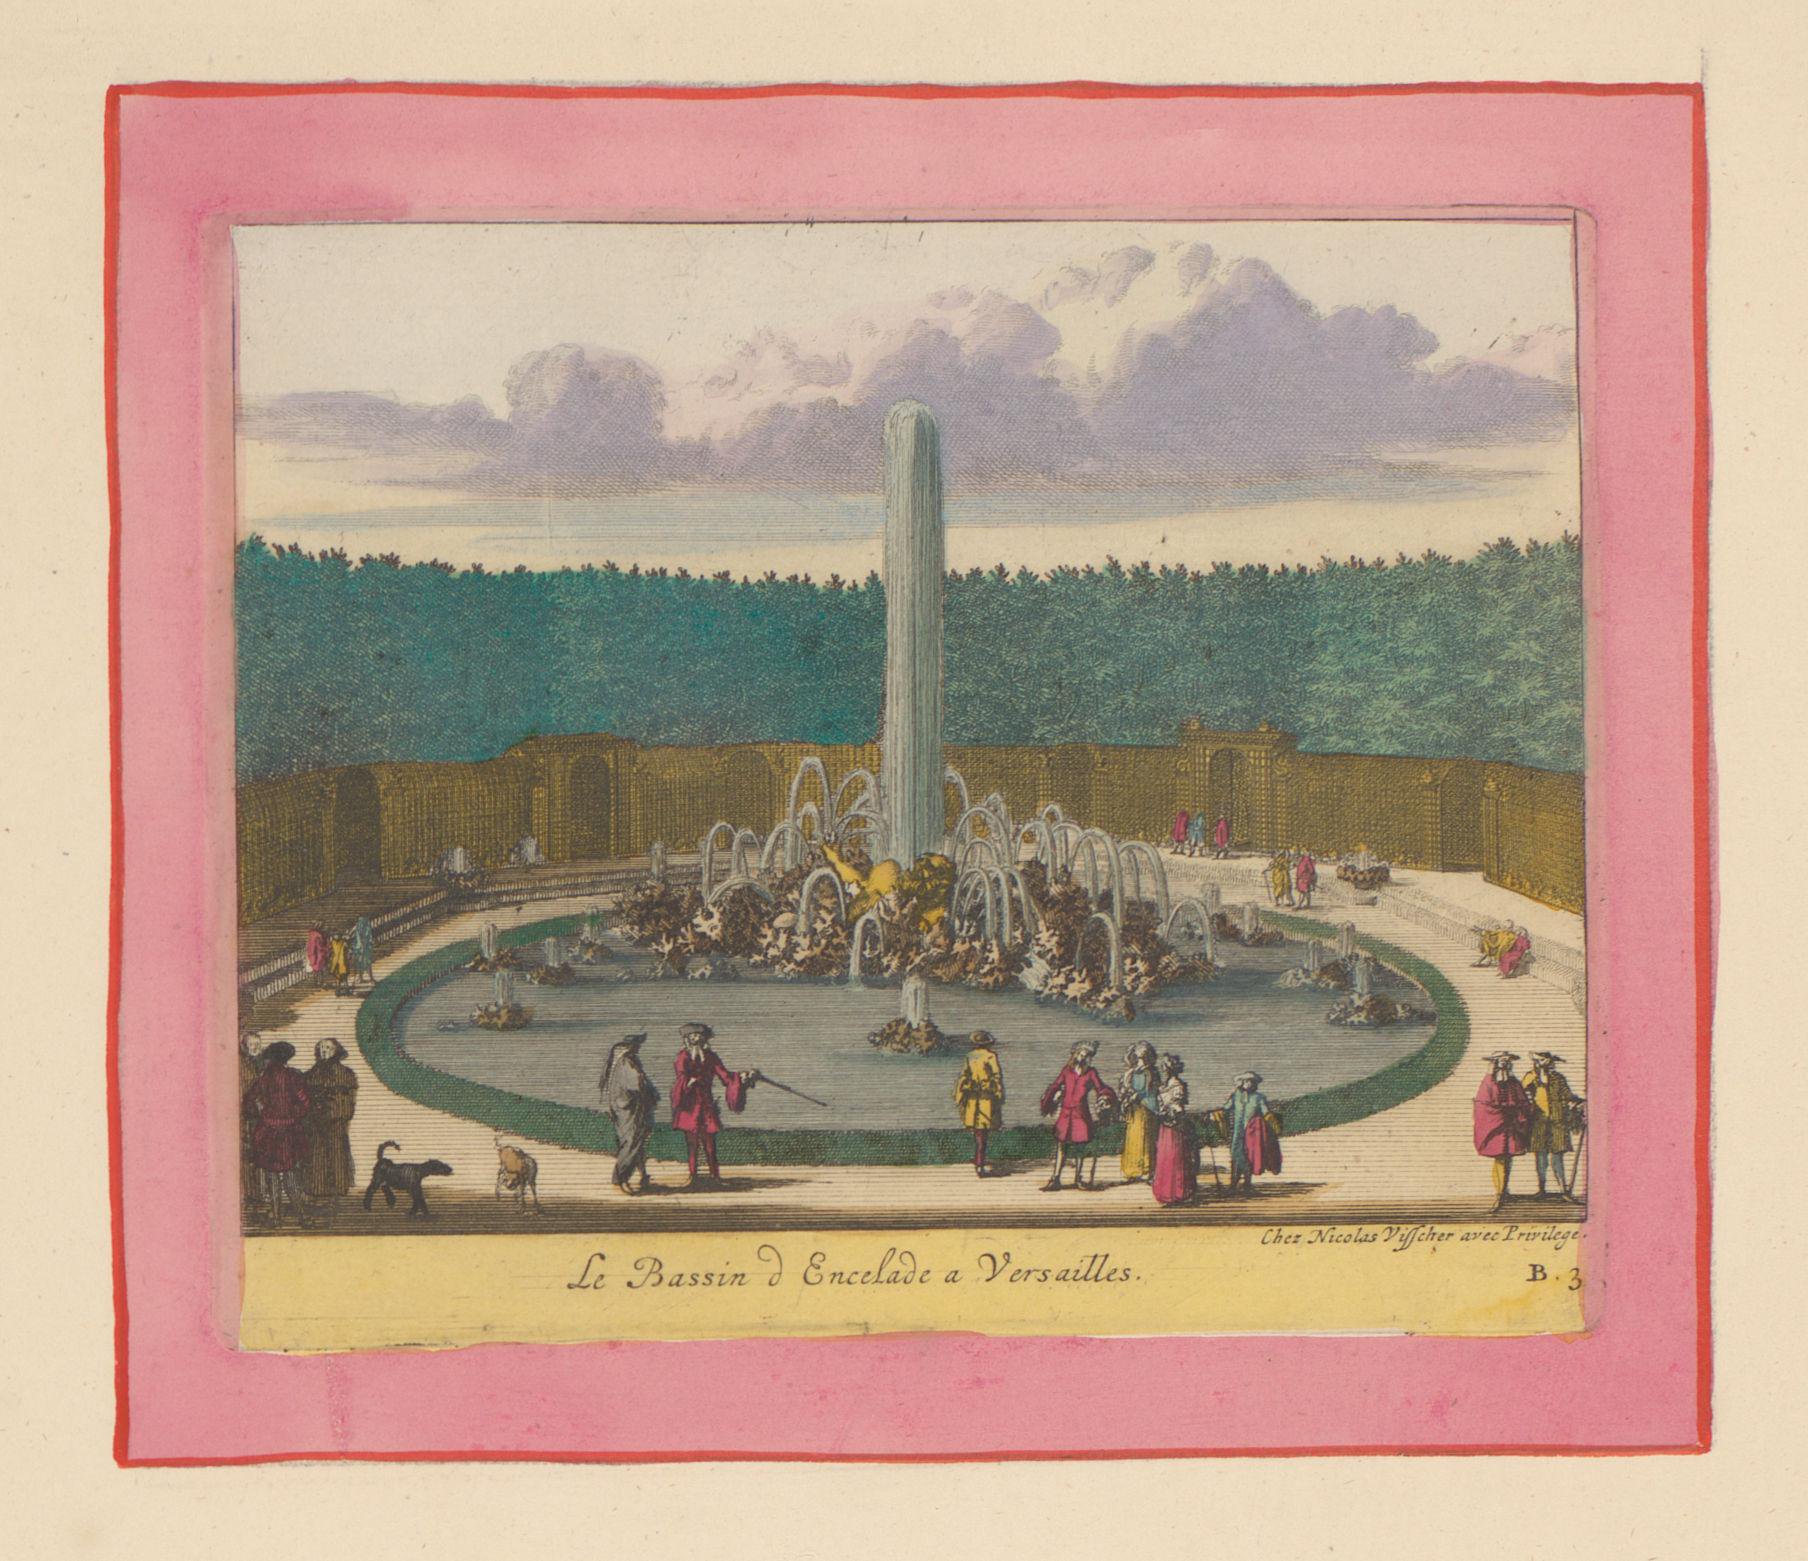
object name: album leaf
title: Fontein van Enceladus in de tuinen van Versailles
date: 1686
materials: paper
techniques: etching, hand coloring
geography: amsterdam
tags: garden fountain, french or architectonic garden; formal garden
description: De fontein van Enceladus in de tuinen van Versailles. In het midden van de fontein de sculptuur van de gigant Enceladus. Rond de fontein wandelaars. Rechtsonder het serienummer: B3. Prent maakt deel uit van een album.